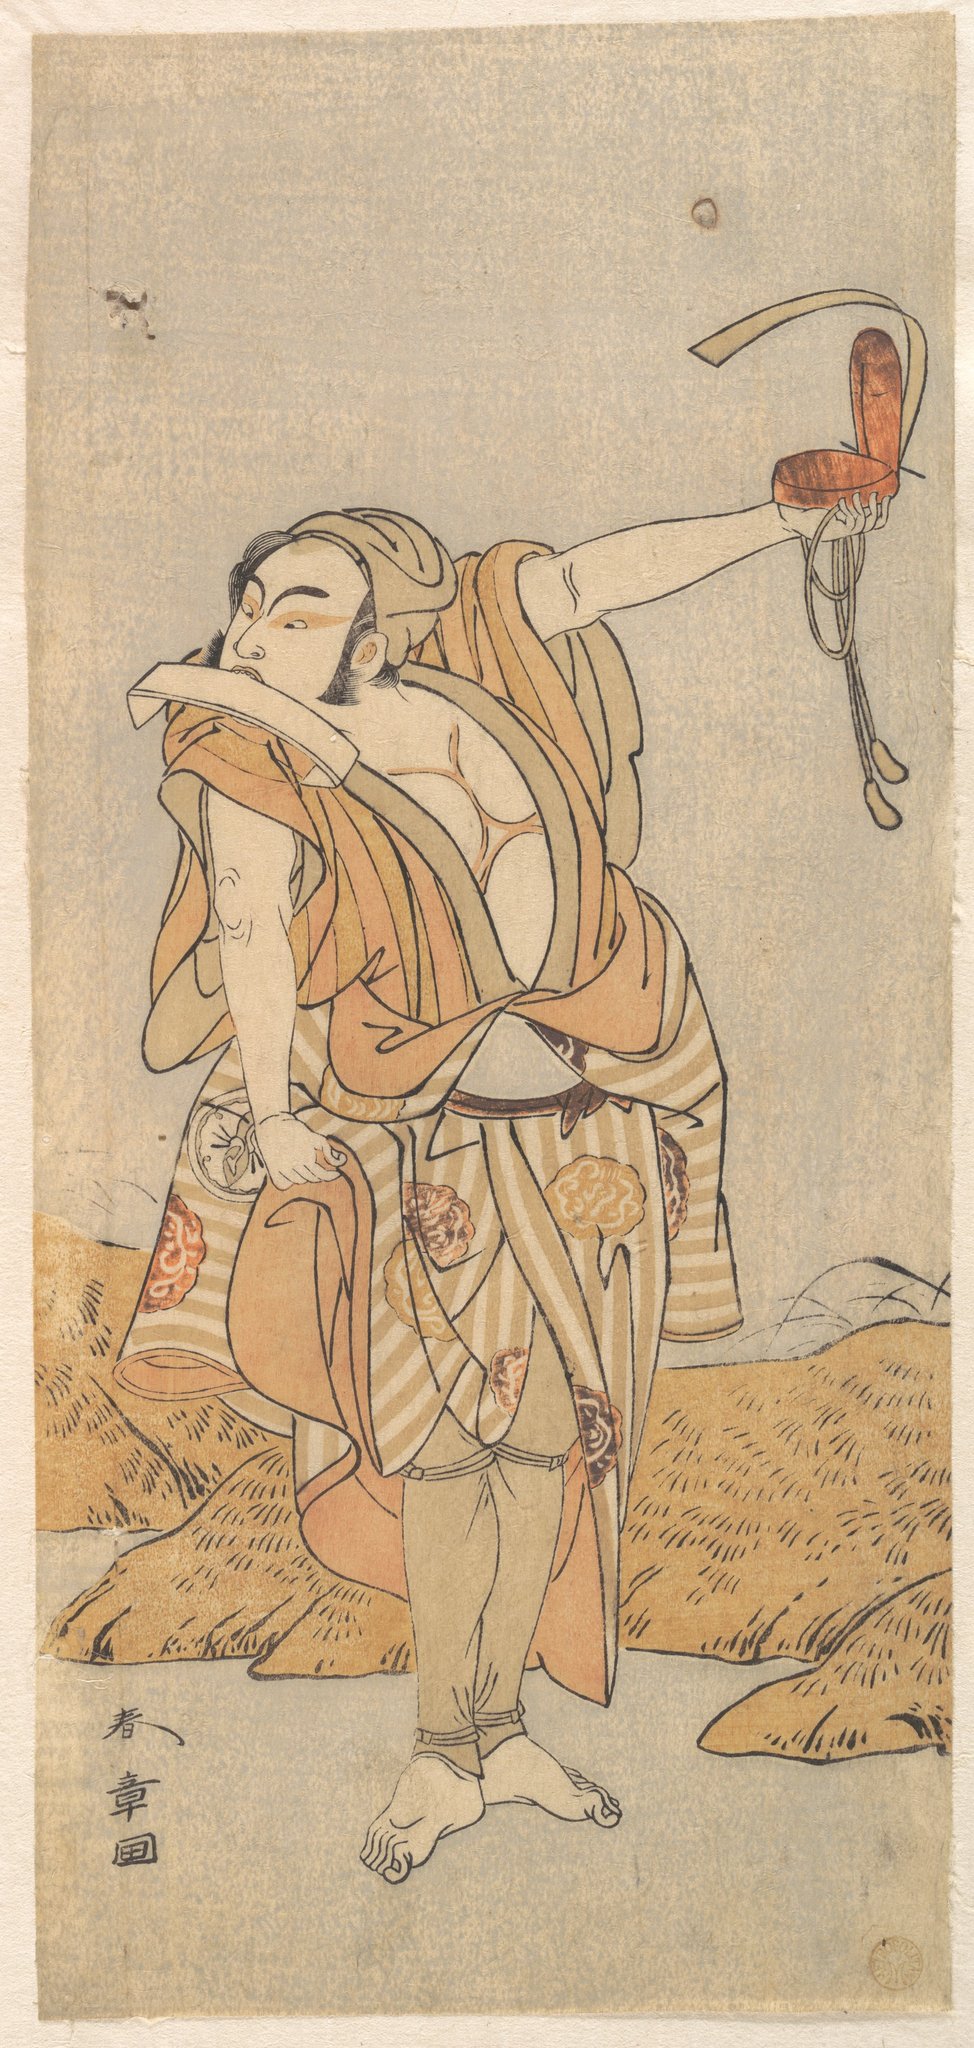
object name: woodblock print nishiki e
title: The Second Nakamura Juzo as a Yakko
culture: japanese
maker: katsukawa shunshō 勝川春章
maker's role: artist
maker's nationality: japanese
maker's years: 1726-1792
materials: ink, paper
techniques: nishiki e, woodblock print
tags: men,actors